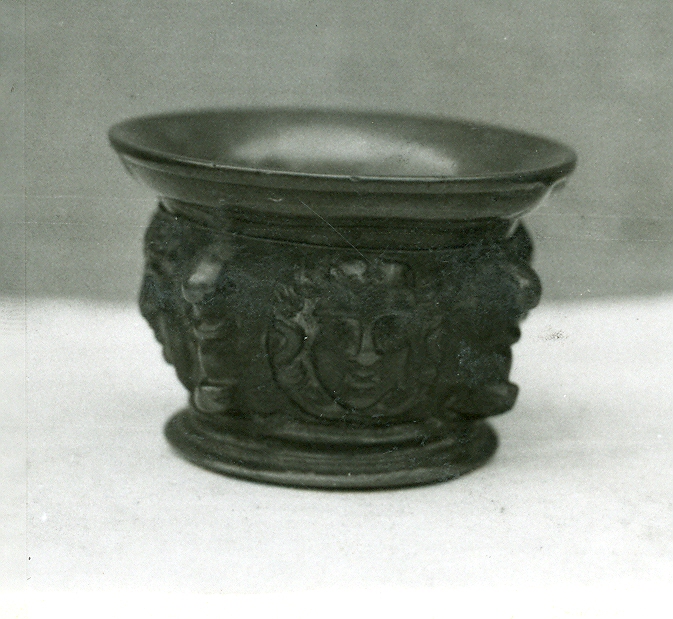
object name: mortar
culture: italian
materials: clay, copper alloy, patina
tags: medusa